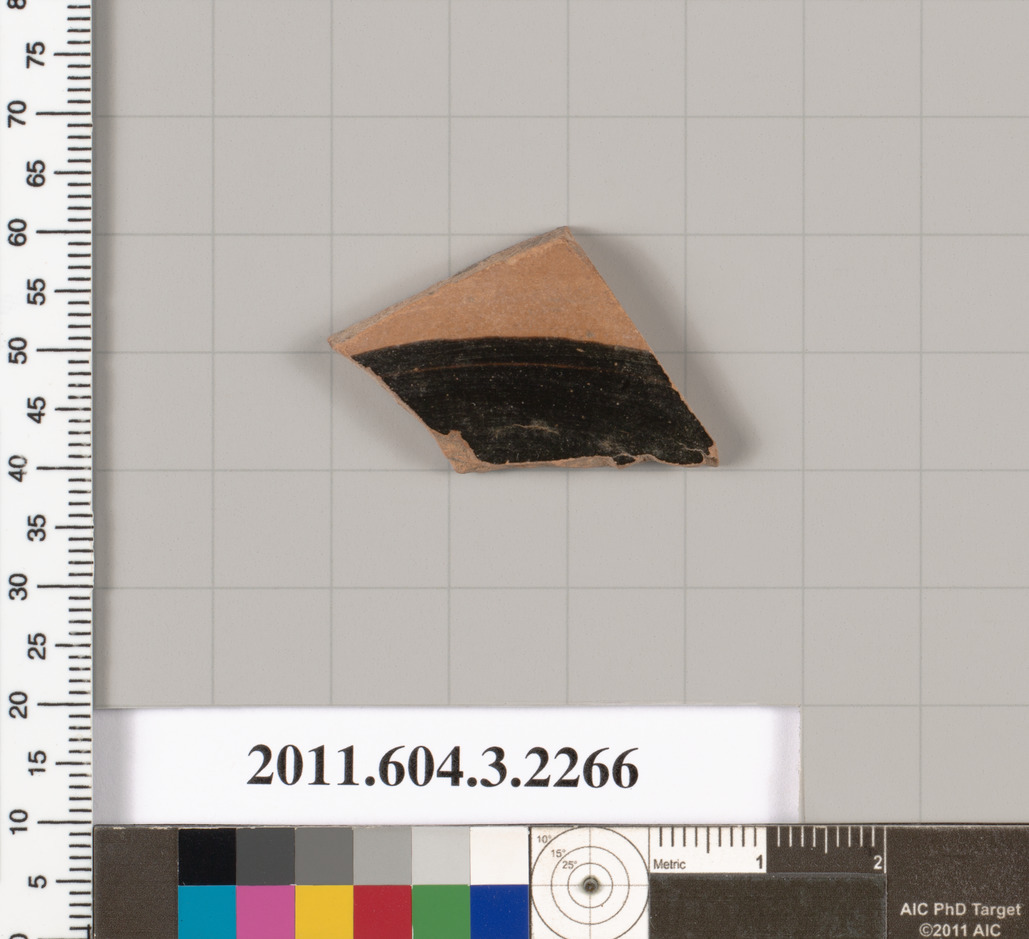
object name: kylix fragment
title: Terracotta fragment of a kylix (drinking cup)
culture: greek, attic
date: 600-401 BCE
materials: terracotta